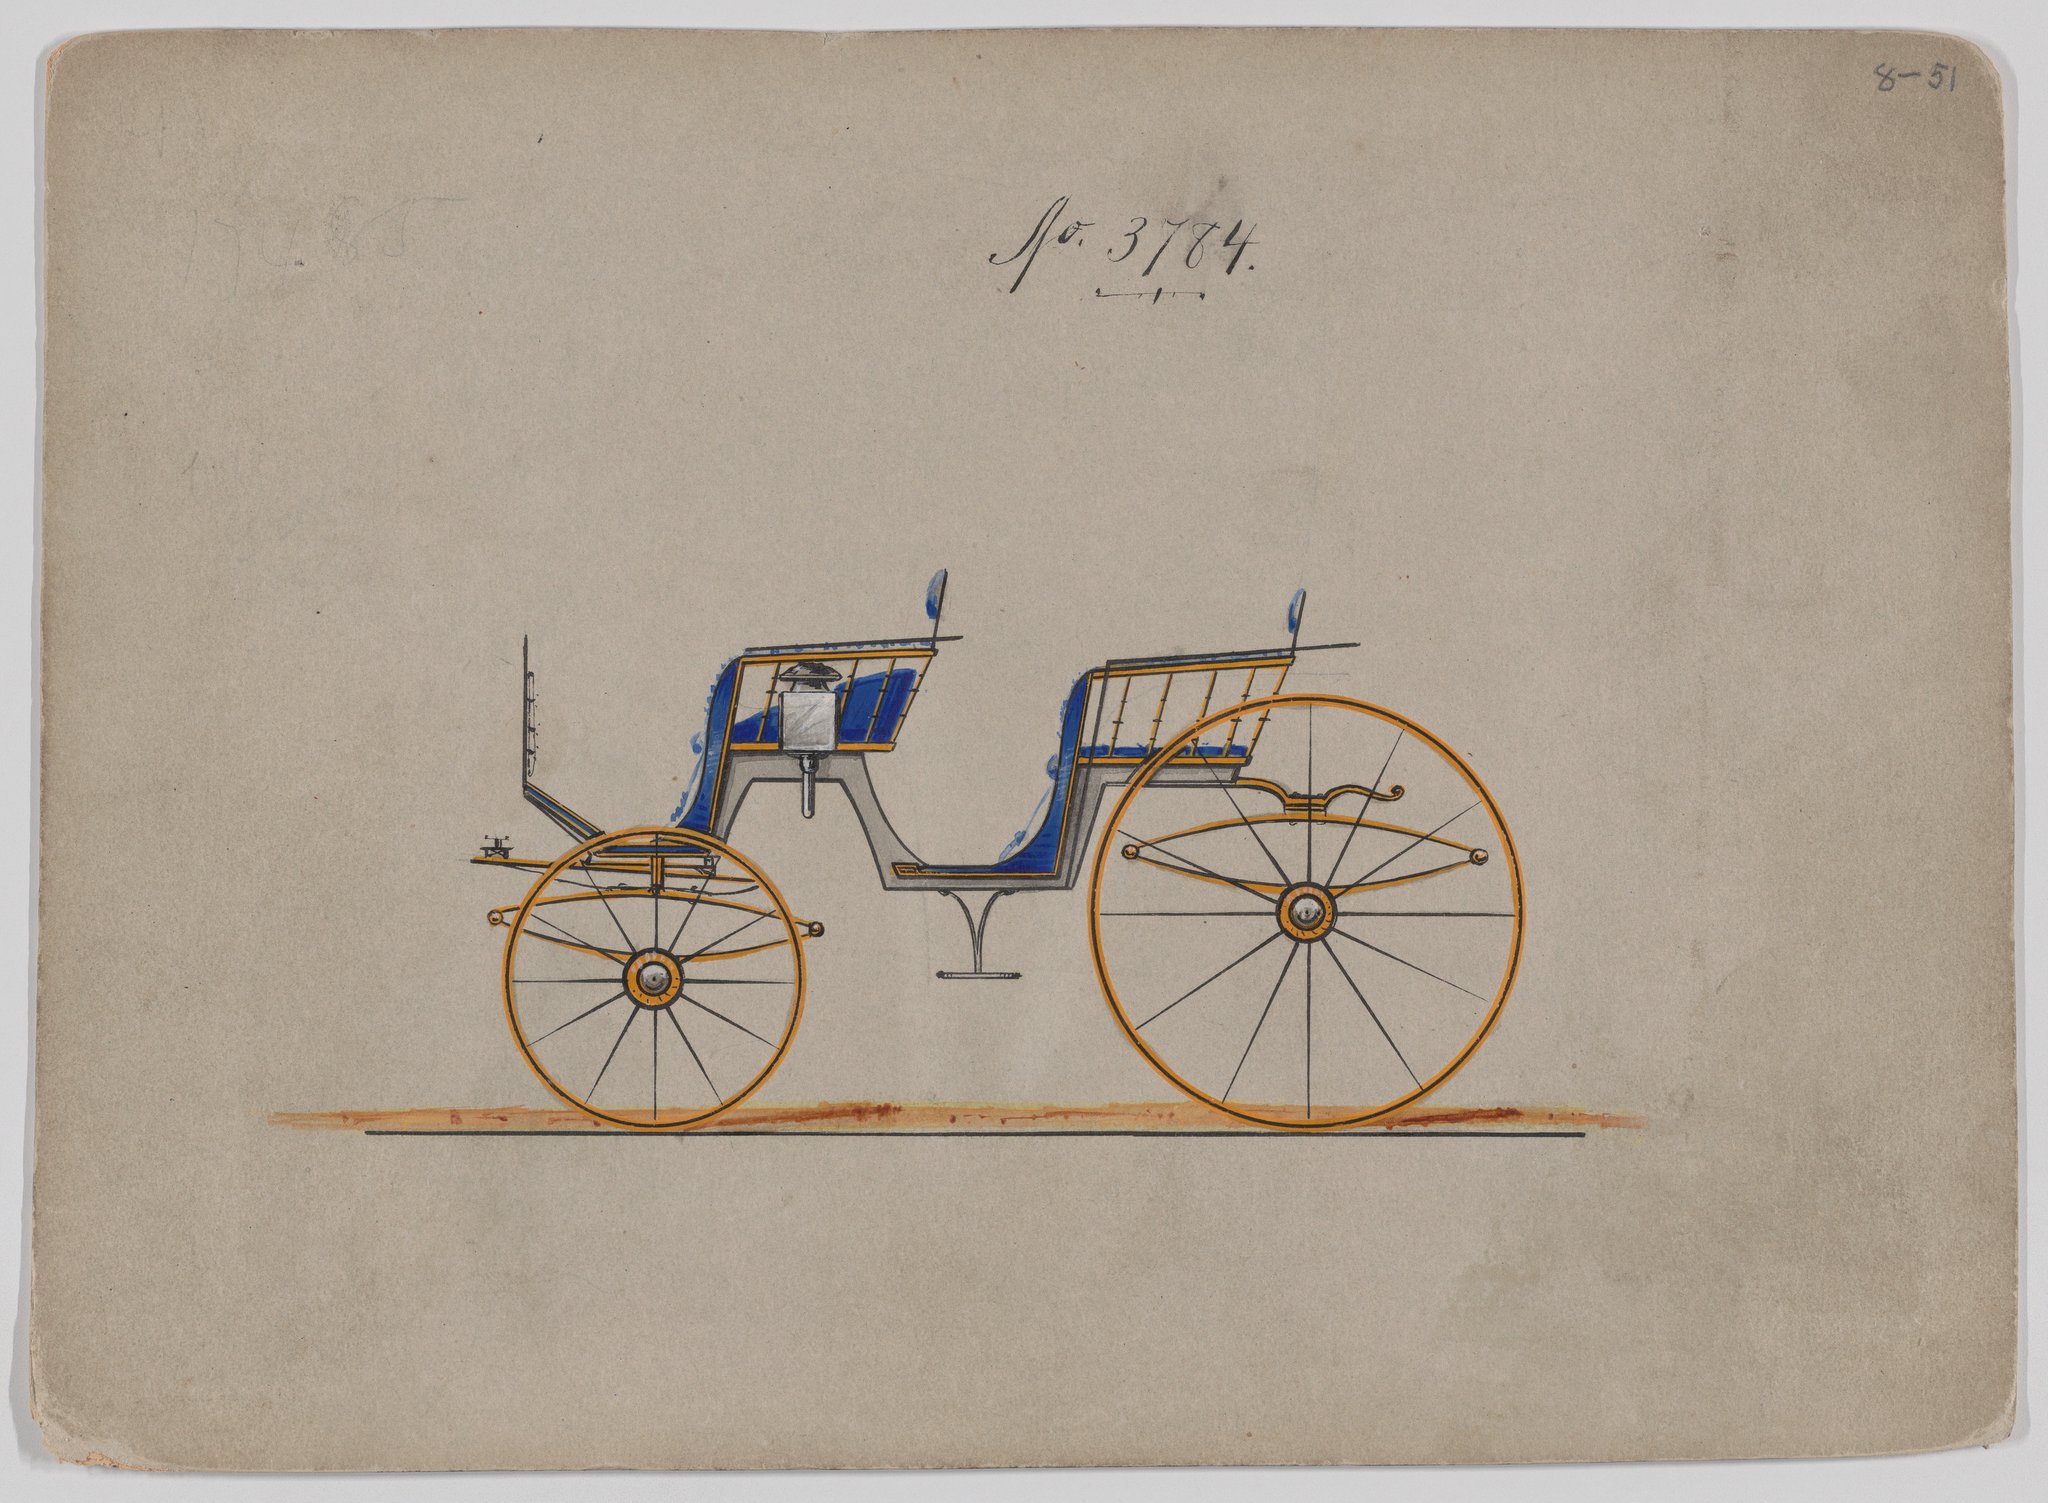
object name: drawing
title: Design for 4 seat Phaeton, no top, no. 3784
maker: brewster & co.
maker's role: manufacturer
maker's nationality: american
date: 1882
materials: gouache, gum arabic, ink, watercolor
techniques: pen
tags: carriages